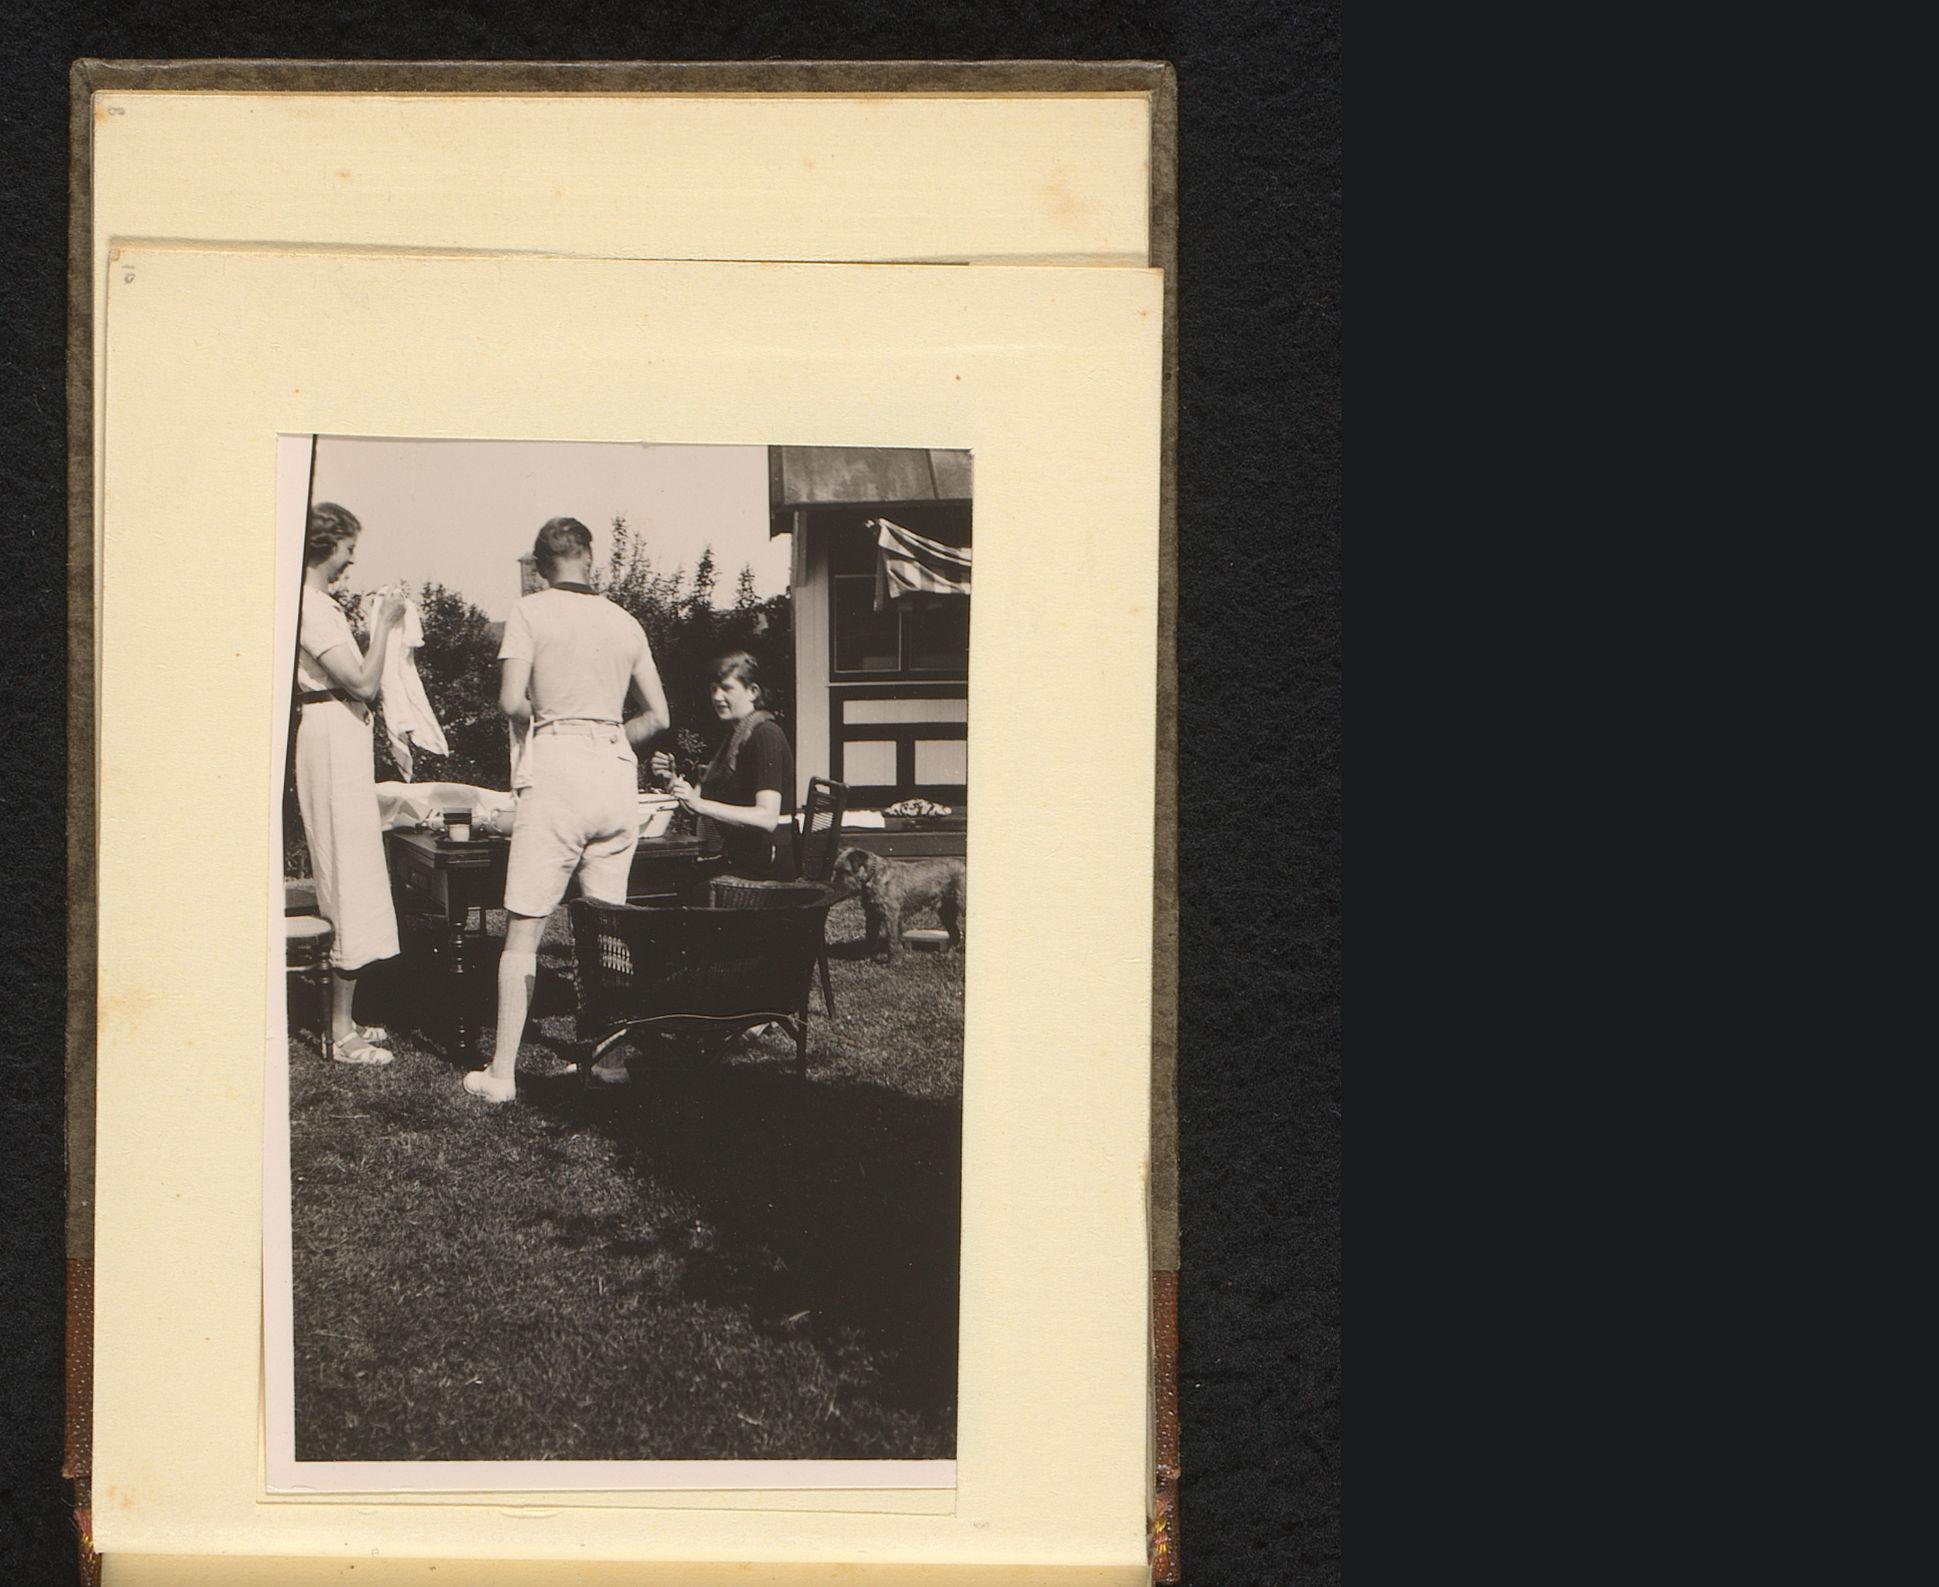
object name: photograph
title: Mensen op een terras in een tuin, rechts een hond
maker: norbert van den berg (1901-1972)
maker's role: amateurfotograaf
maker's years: 1901-1972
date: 1935-1950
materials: paper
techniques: gelatin silver print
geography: netherlands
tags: garden, terrace, dog